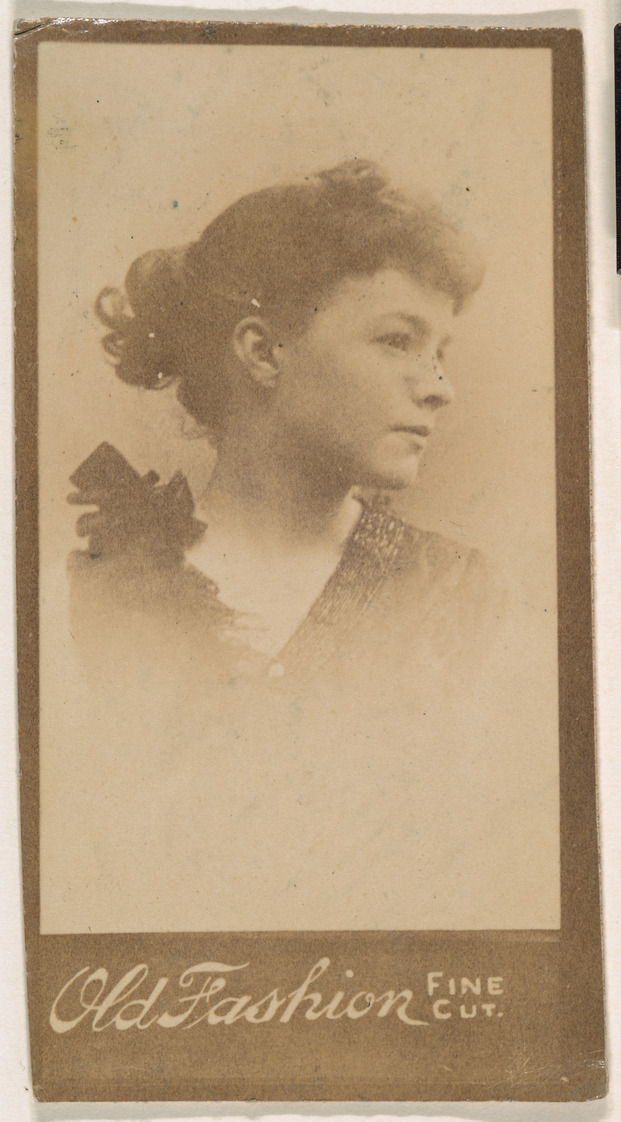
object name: photograph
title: Portrait of actress in profile, from the Actresses series (N664) promoting Old Fashion Fine Cut Tobacco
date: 1888-1890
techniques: albumen silver print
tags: portraits,women,actresses